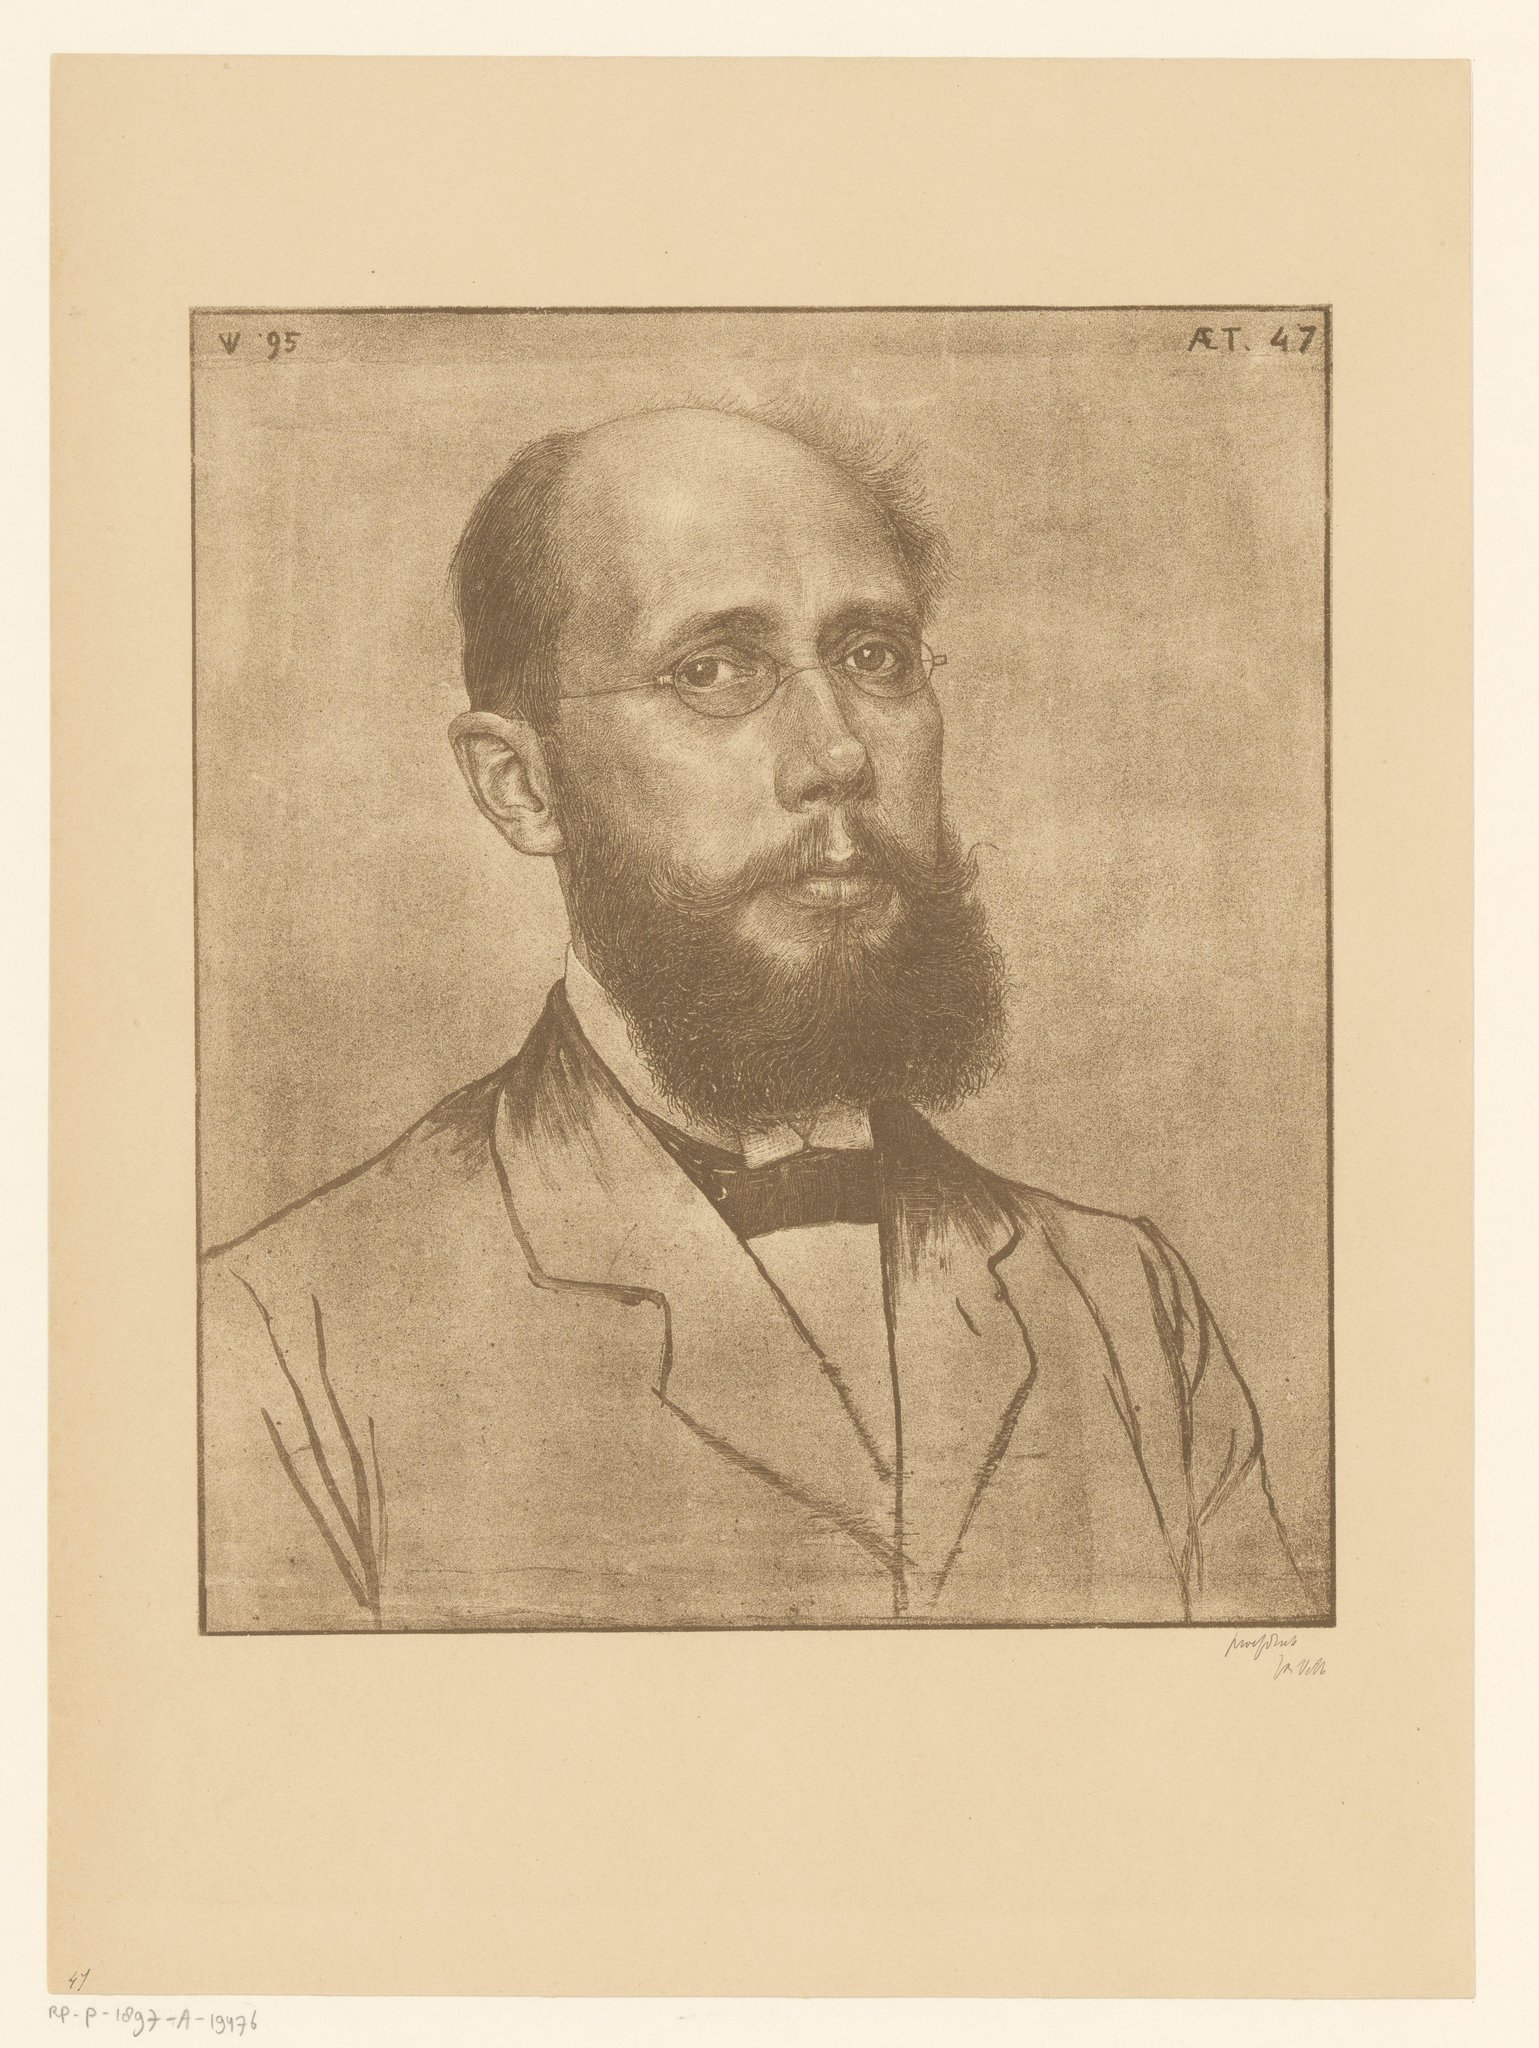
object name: print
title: Portret van Samuel Muller Fz.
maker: jan veth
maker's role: designer, draughtsman, painter, print maker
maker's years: 1864-1925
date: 1895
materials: paper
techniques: lithograph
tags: samuel muller (1848-1922), historical persons (+ (full) bust portrait)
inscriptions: inscription: ‘proefdruk / Jan Veth’, collector's mark: Lugt 2228